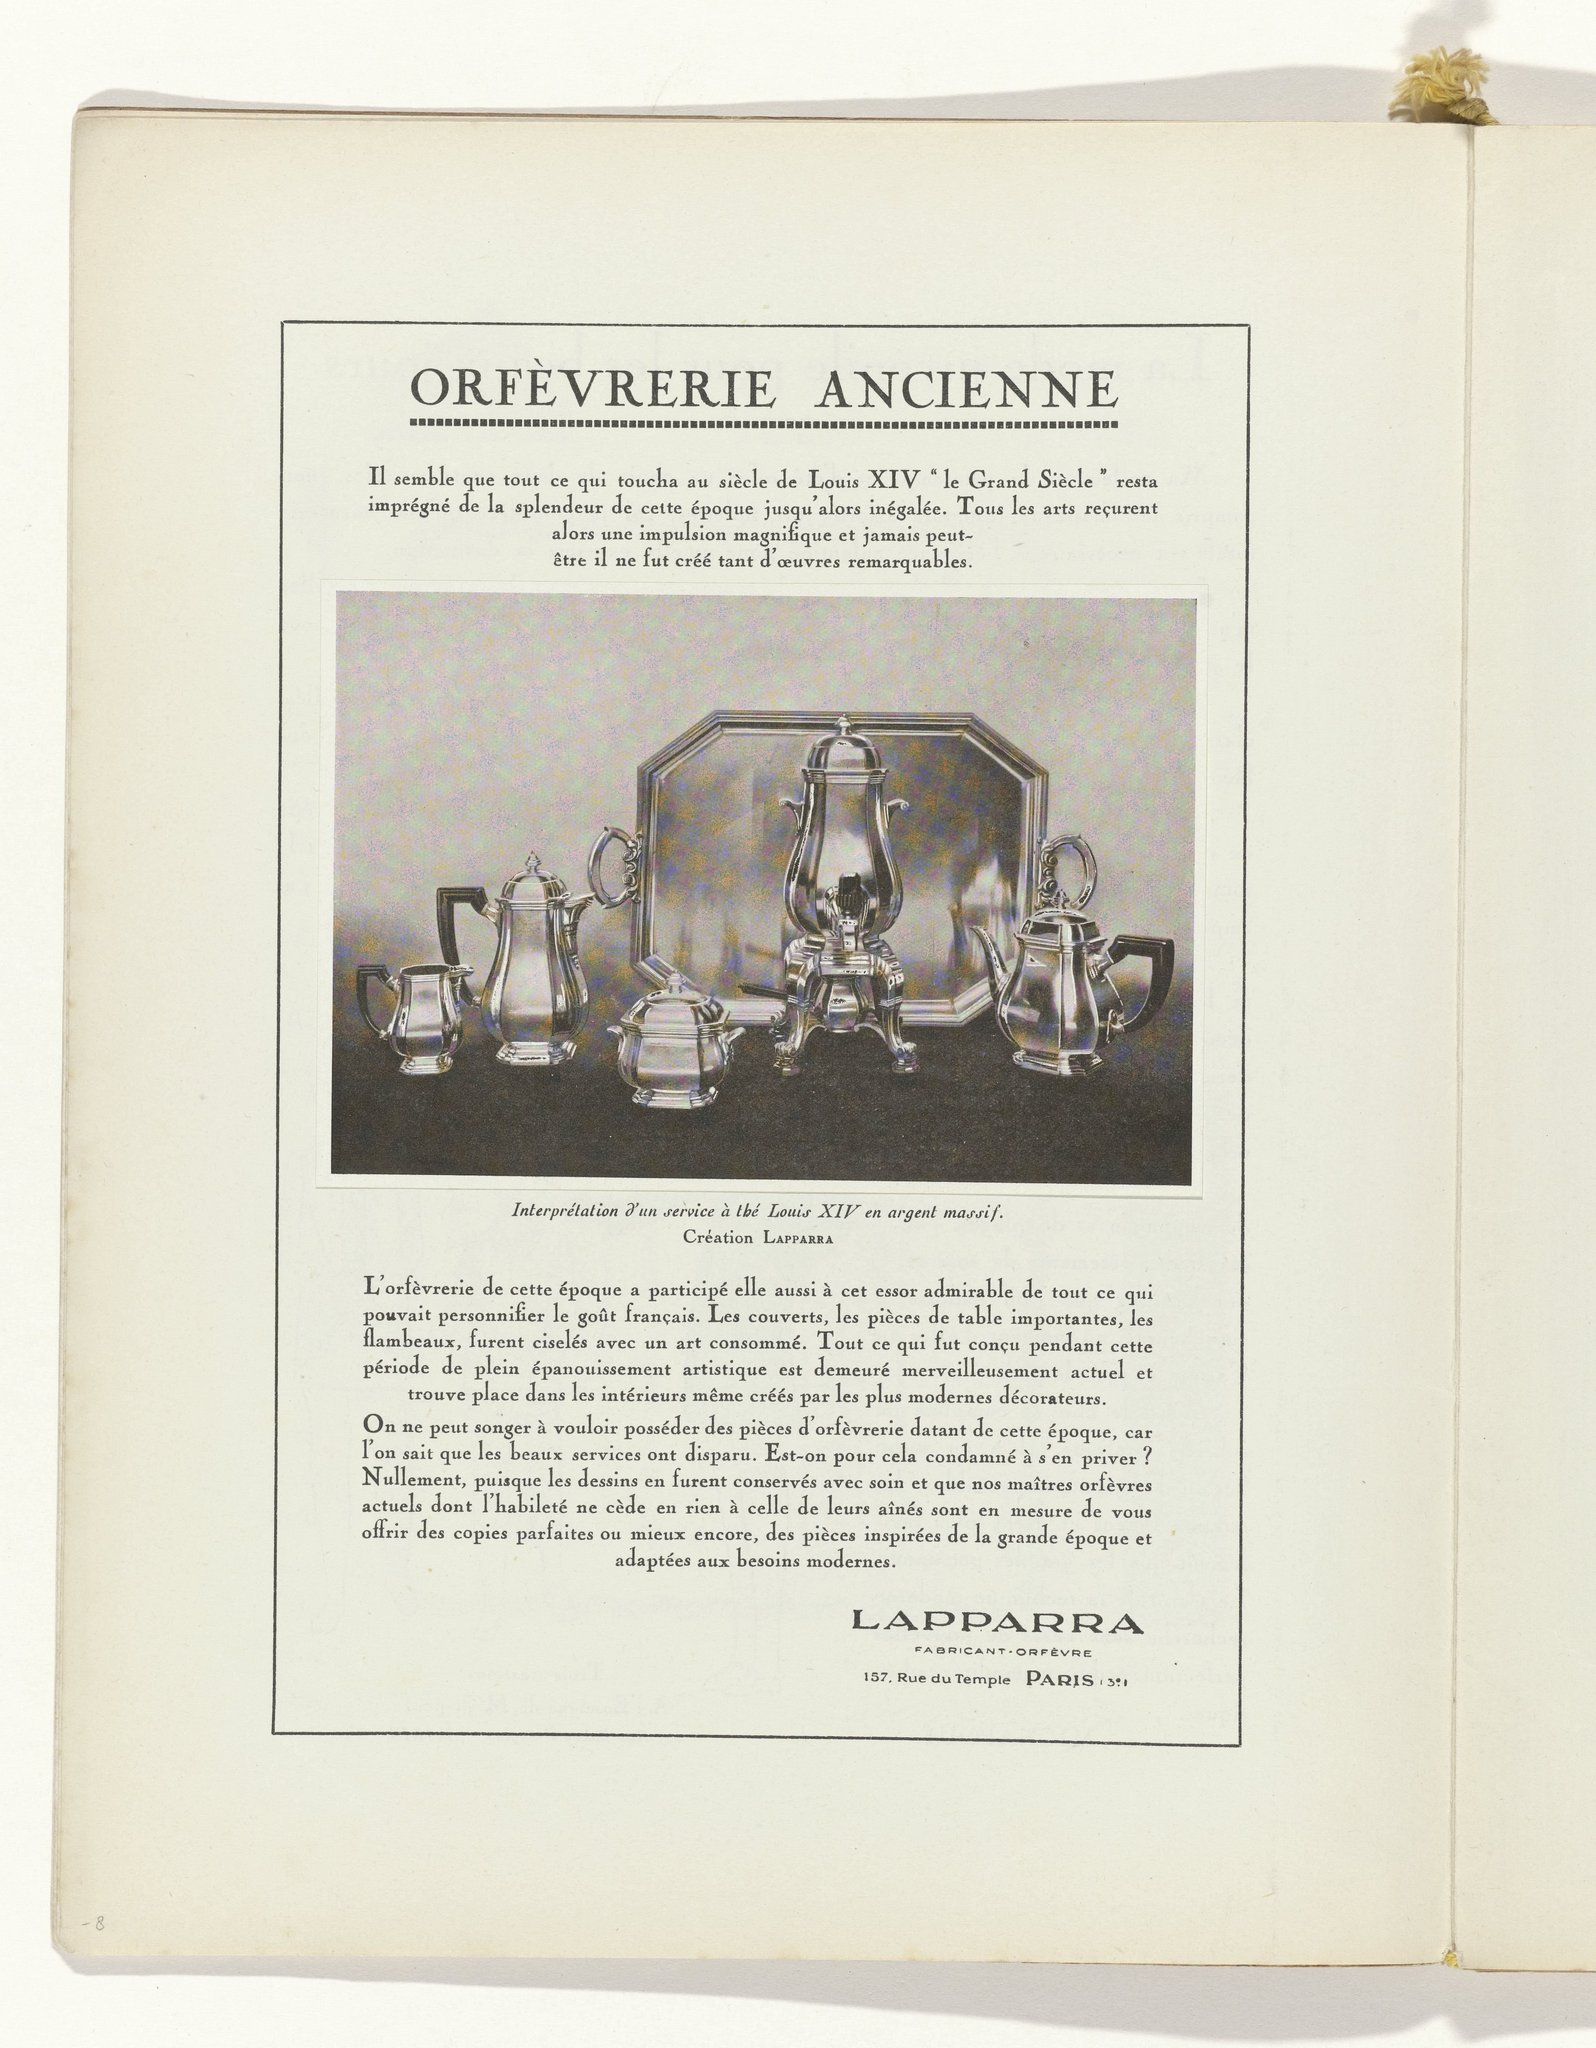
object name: magazine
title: Art - Goût - Beauté, Feuillets de l' élégance féminine, Mai 1929, No. 105, 9e Année, p. 8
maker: charles goy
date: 1929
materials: paper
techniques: lithograph, photography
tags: tea- and coffee-service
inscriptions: caption: ‘Interprétation d'un service à thé Louis XIV en argent massif. Création LAPPARRA’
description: Tekst met afbeelding van een zilveren theeservies 'Louis XIV' van Lapparra. Pagina uit het modetijdschrift Art-Goût-Beauté (1920-1933).